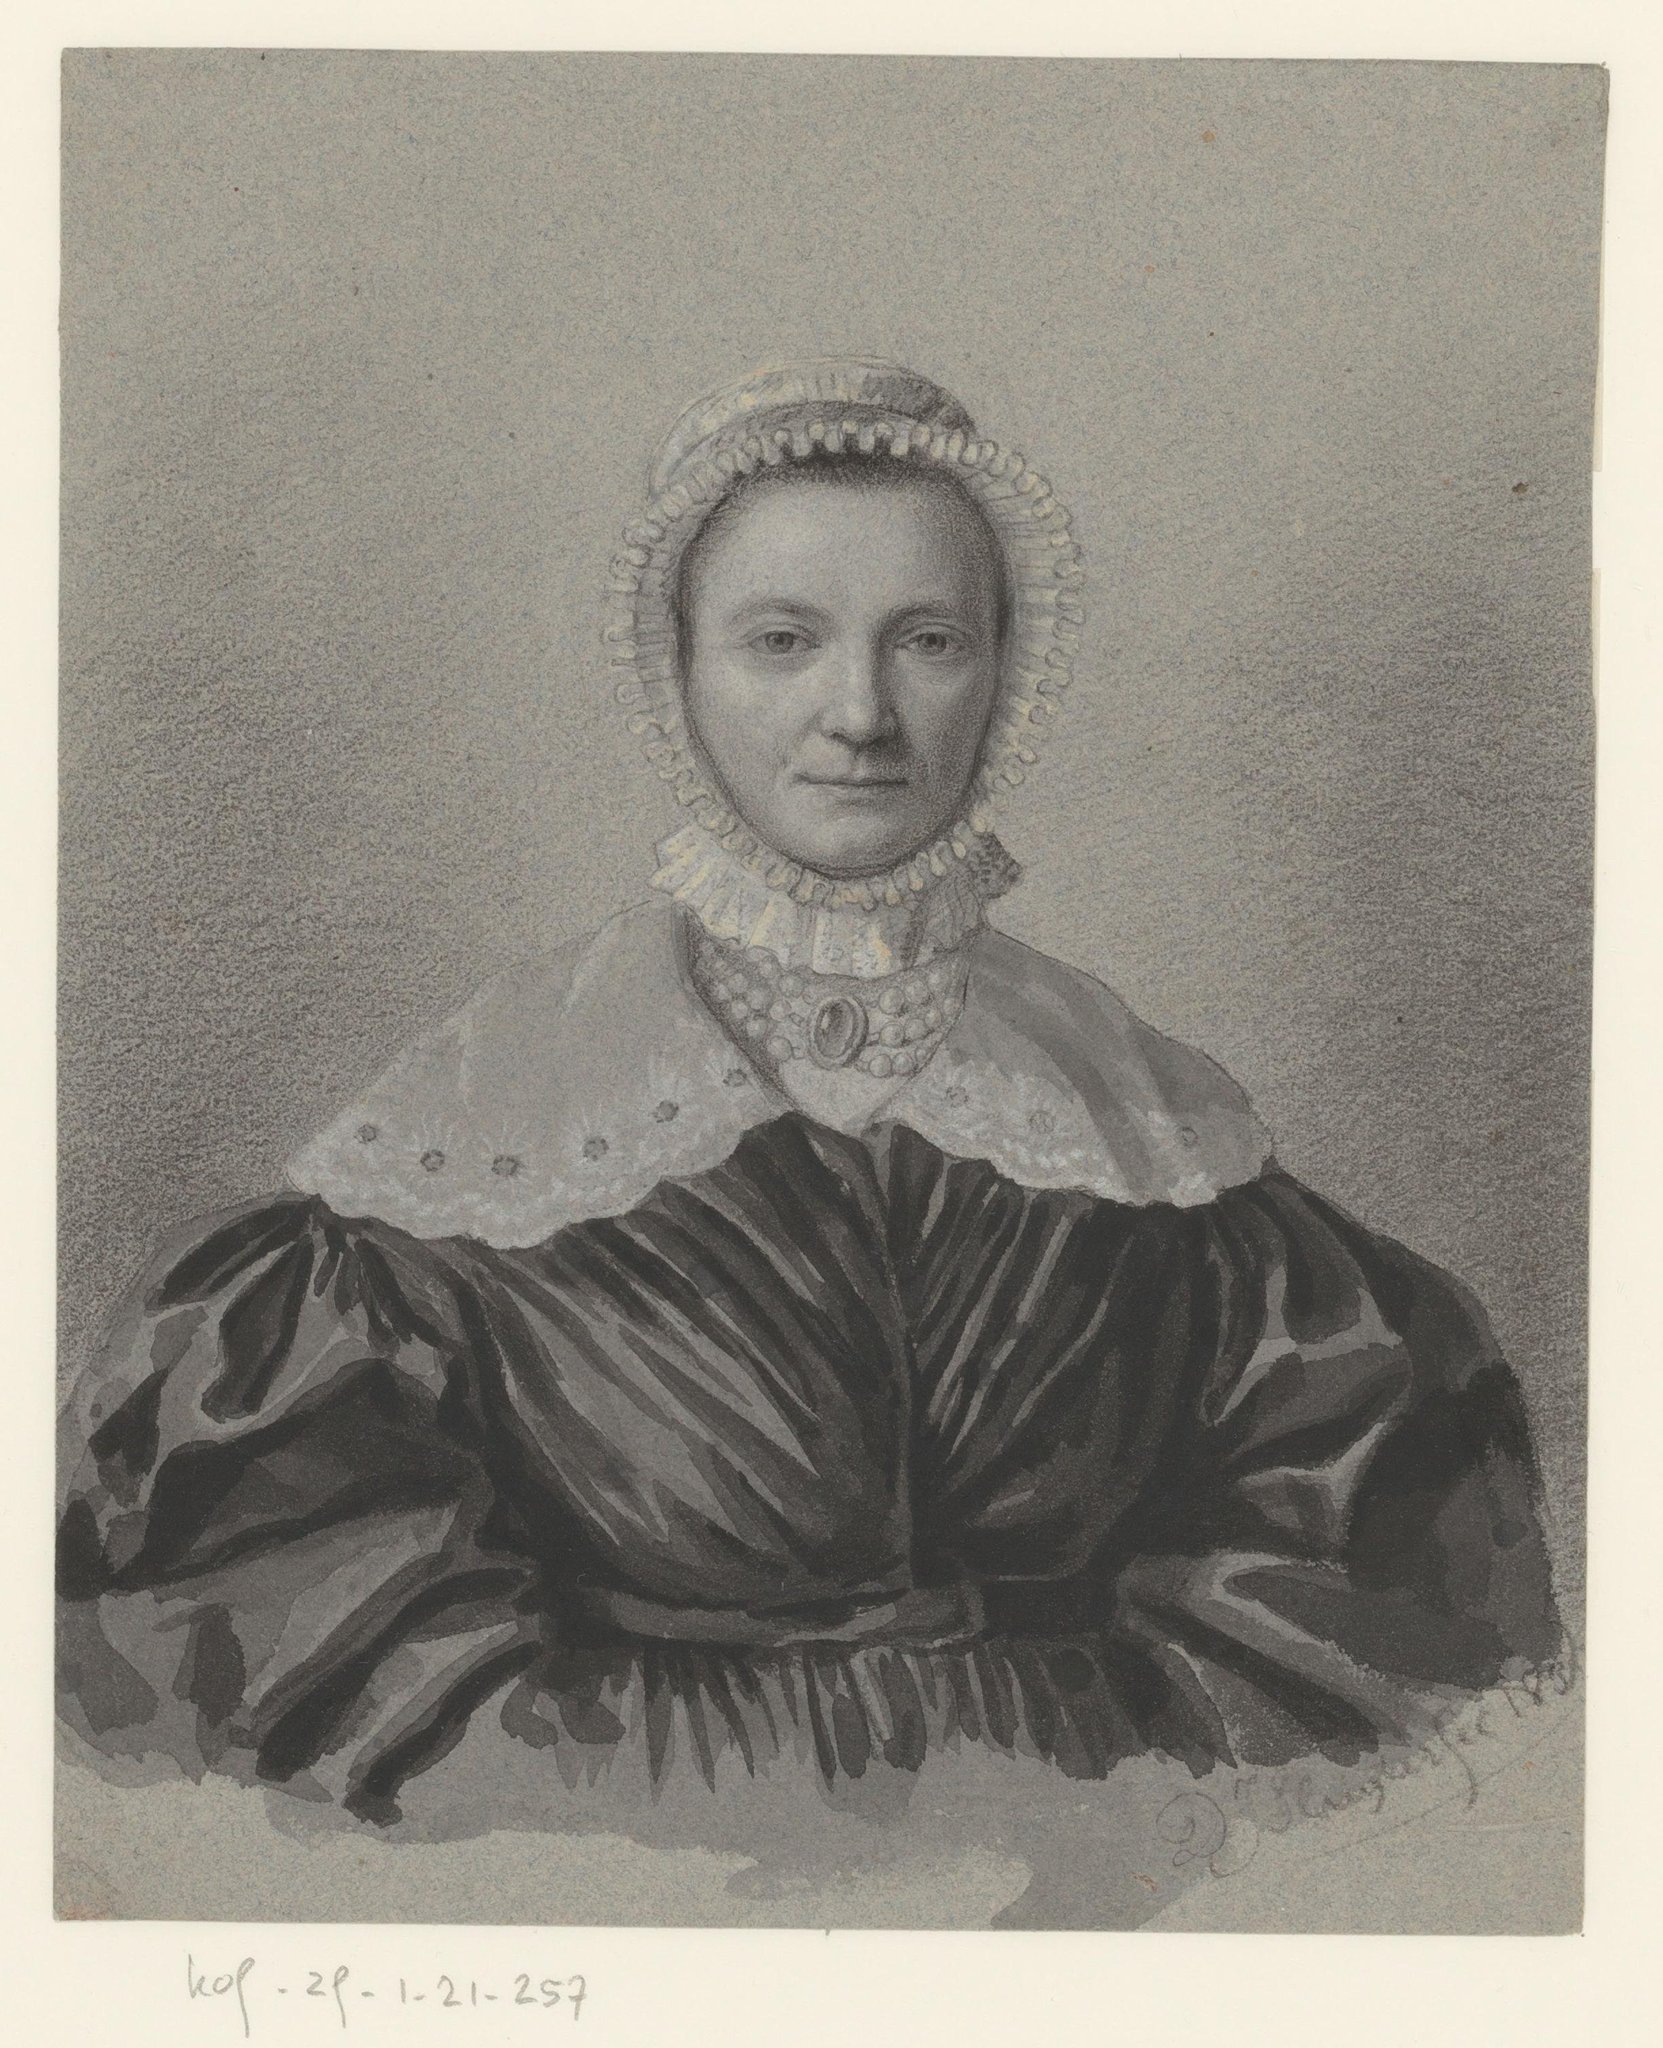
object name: drawing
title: Portret van de zus van Dirk Jurriaan Sluyter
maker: dirk jurriaan sluyter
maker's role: draughtsman, print maker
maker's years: 1811-1886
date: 1835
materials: chalk, ink, paper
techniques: brush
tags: historical persons - bb - woman, head-gear: cap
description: Onderwerpsrubrieken binnen de Atlas Zeden en Gewoonten: Zeden en Gewoonten in Engeren Zin, De Kleeding, Kleederdrachten (tijdvakken), De regeering van Willem I. Mannen en vrouwen.